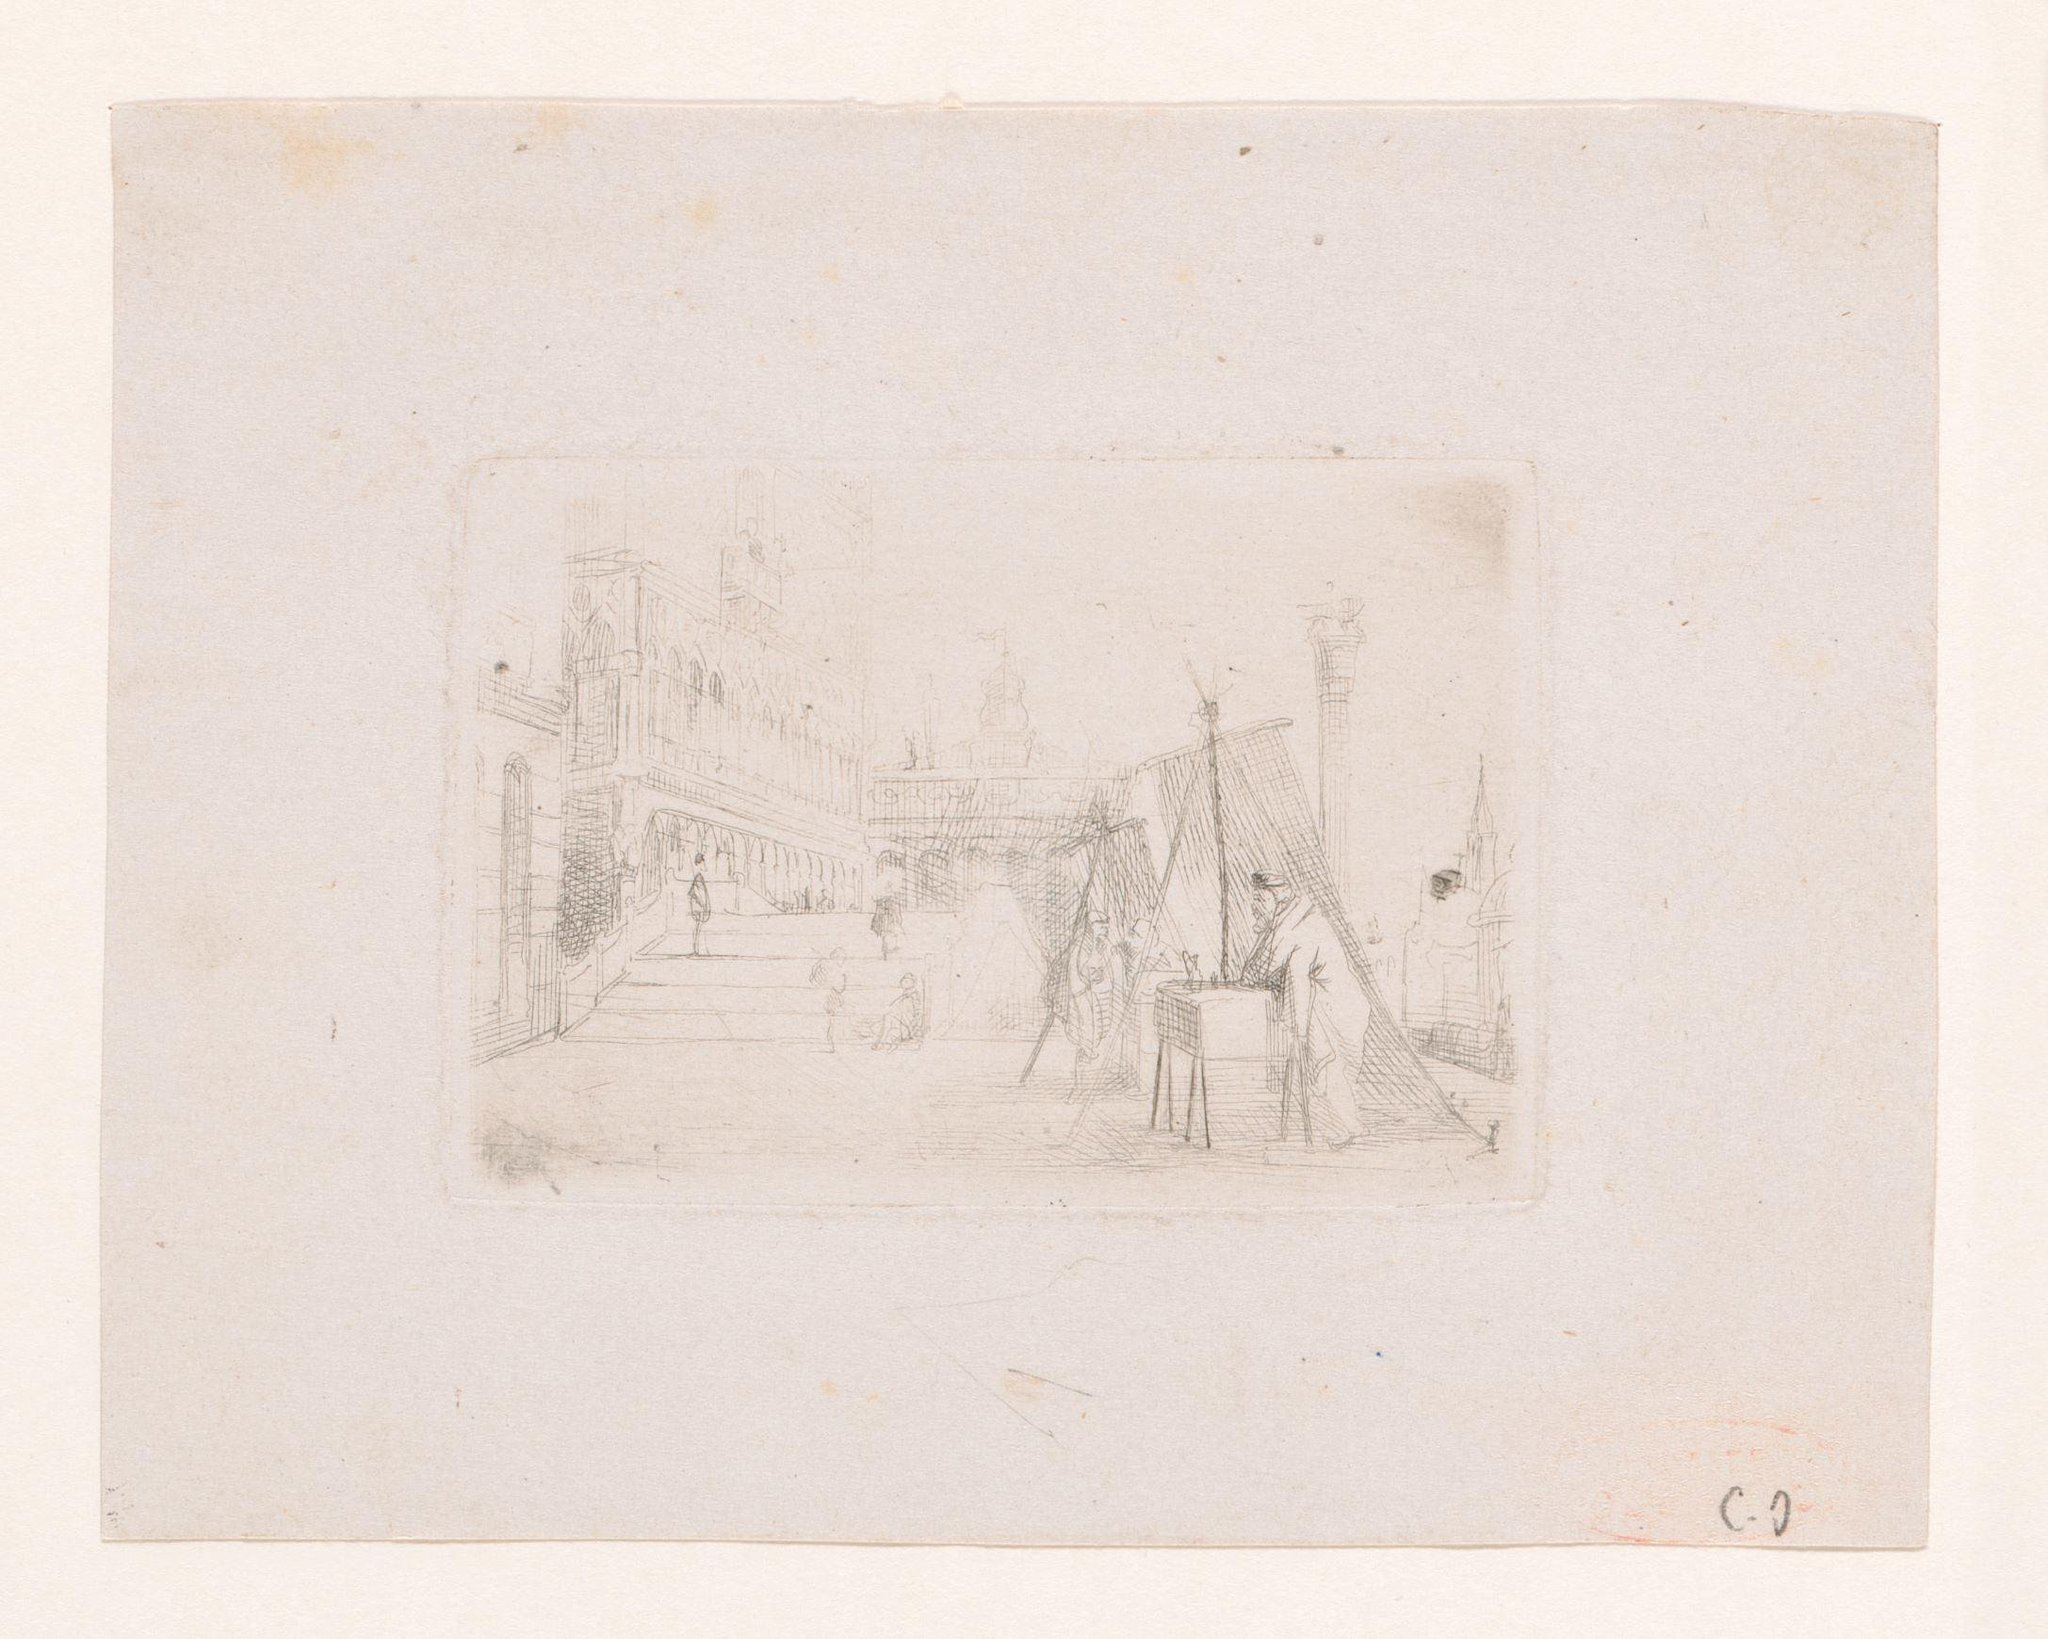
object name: print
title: Gezicht op het Dogepaleis in Venetië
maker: corneille seghers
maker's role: draughtsman, print maker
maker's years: 1814-1869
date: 1824-1869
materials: paper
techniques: etching, intaglio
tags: palace, venice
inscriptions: collector's mark: Lugt 2228